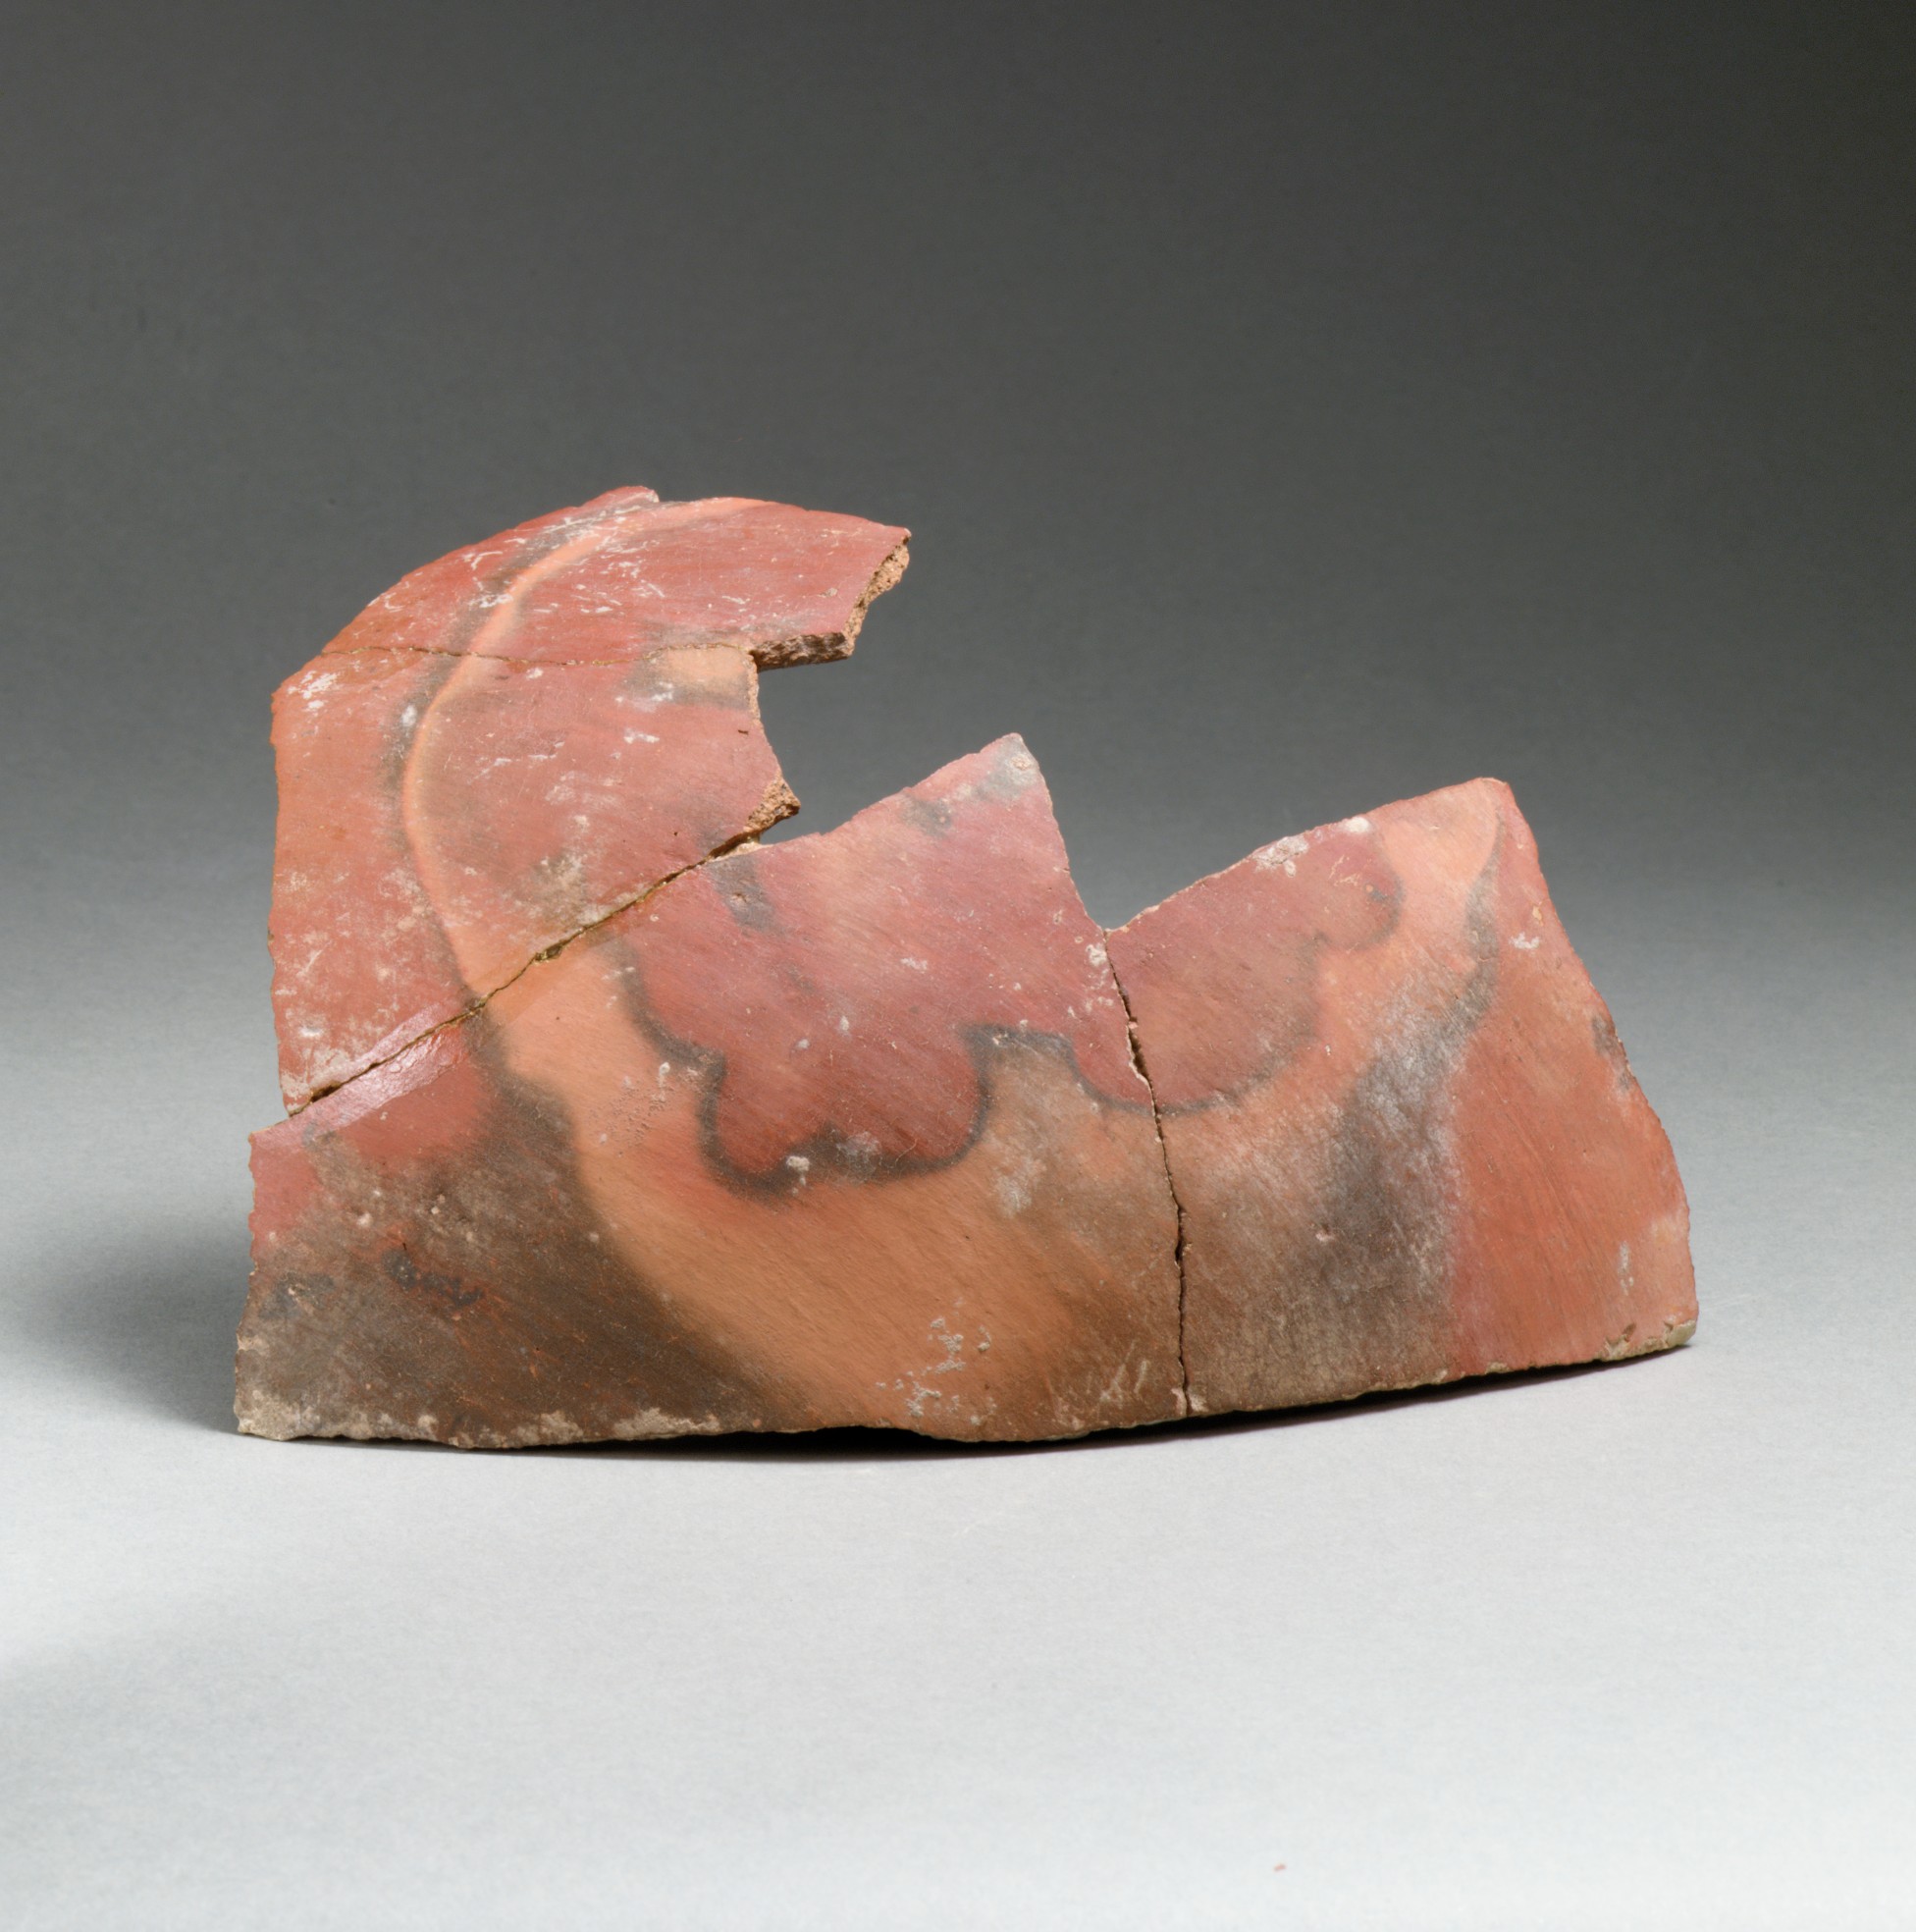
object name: vase fragment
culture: minoan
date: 2600-2000 BCE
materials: terracotta